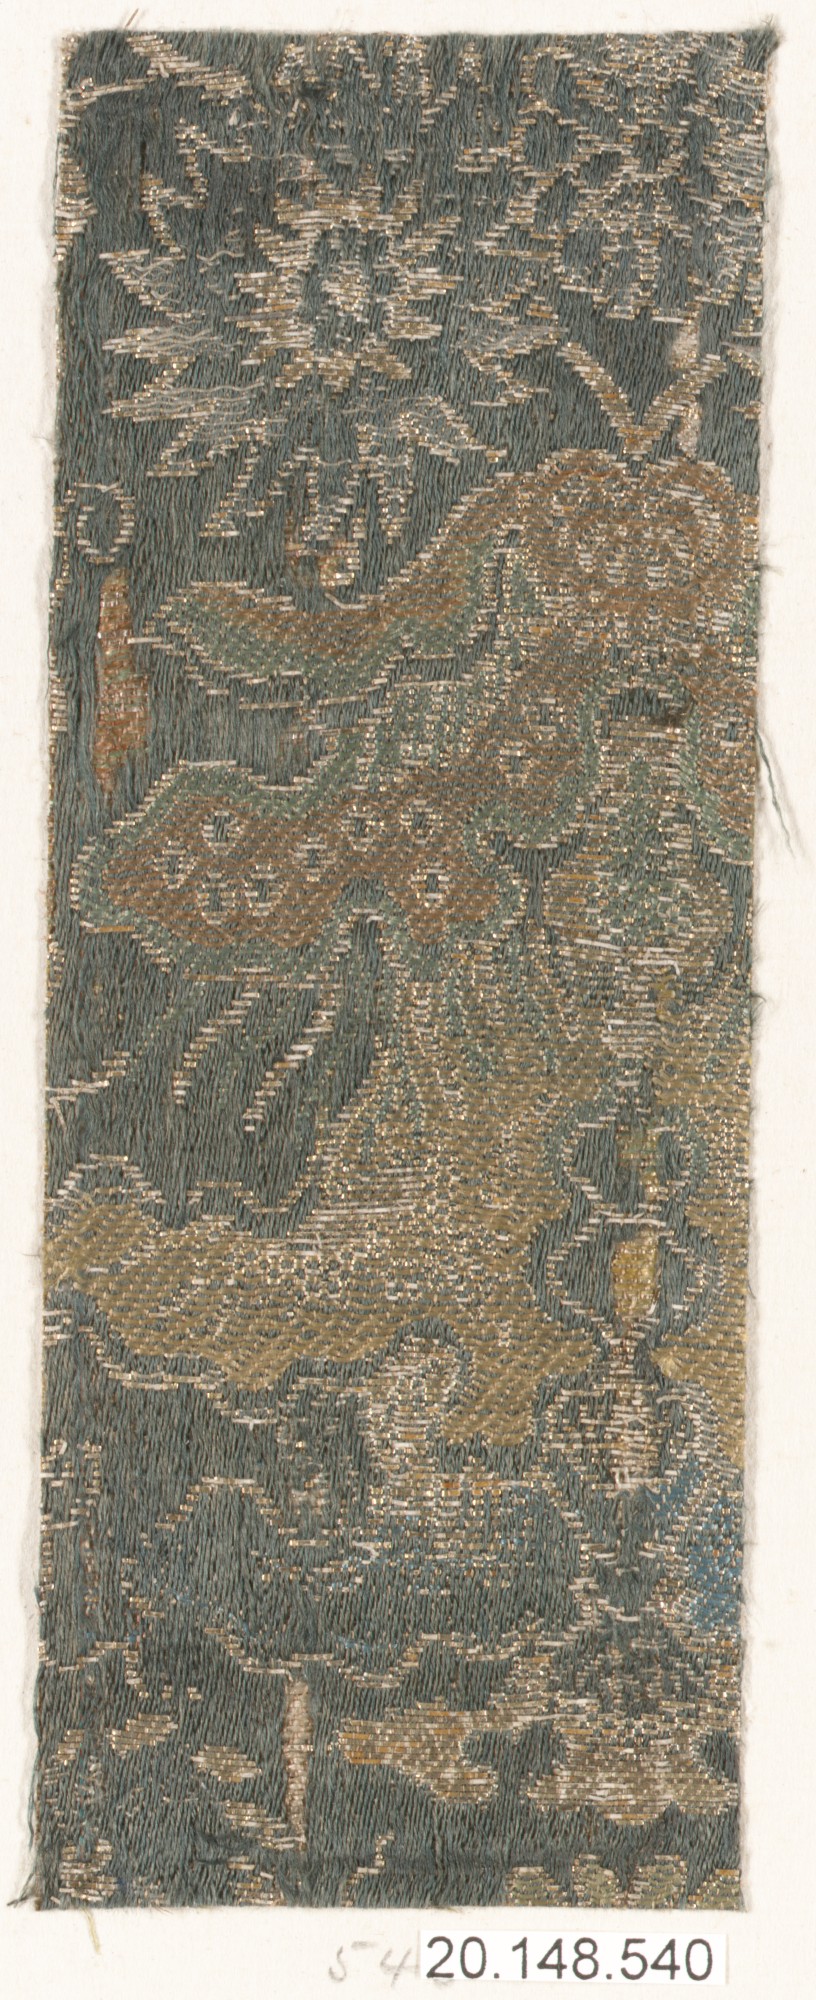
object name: piece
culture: japanese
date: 1701-1800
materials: silk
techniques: compound weave